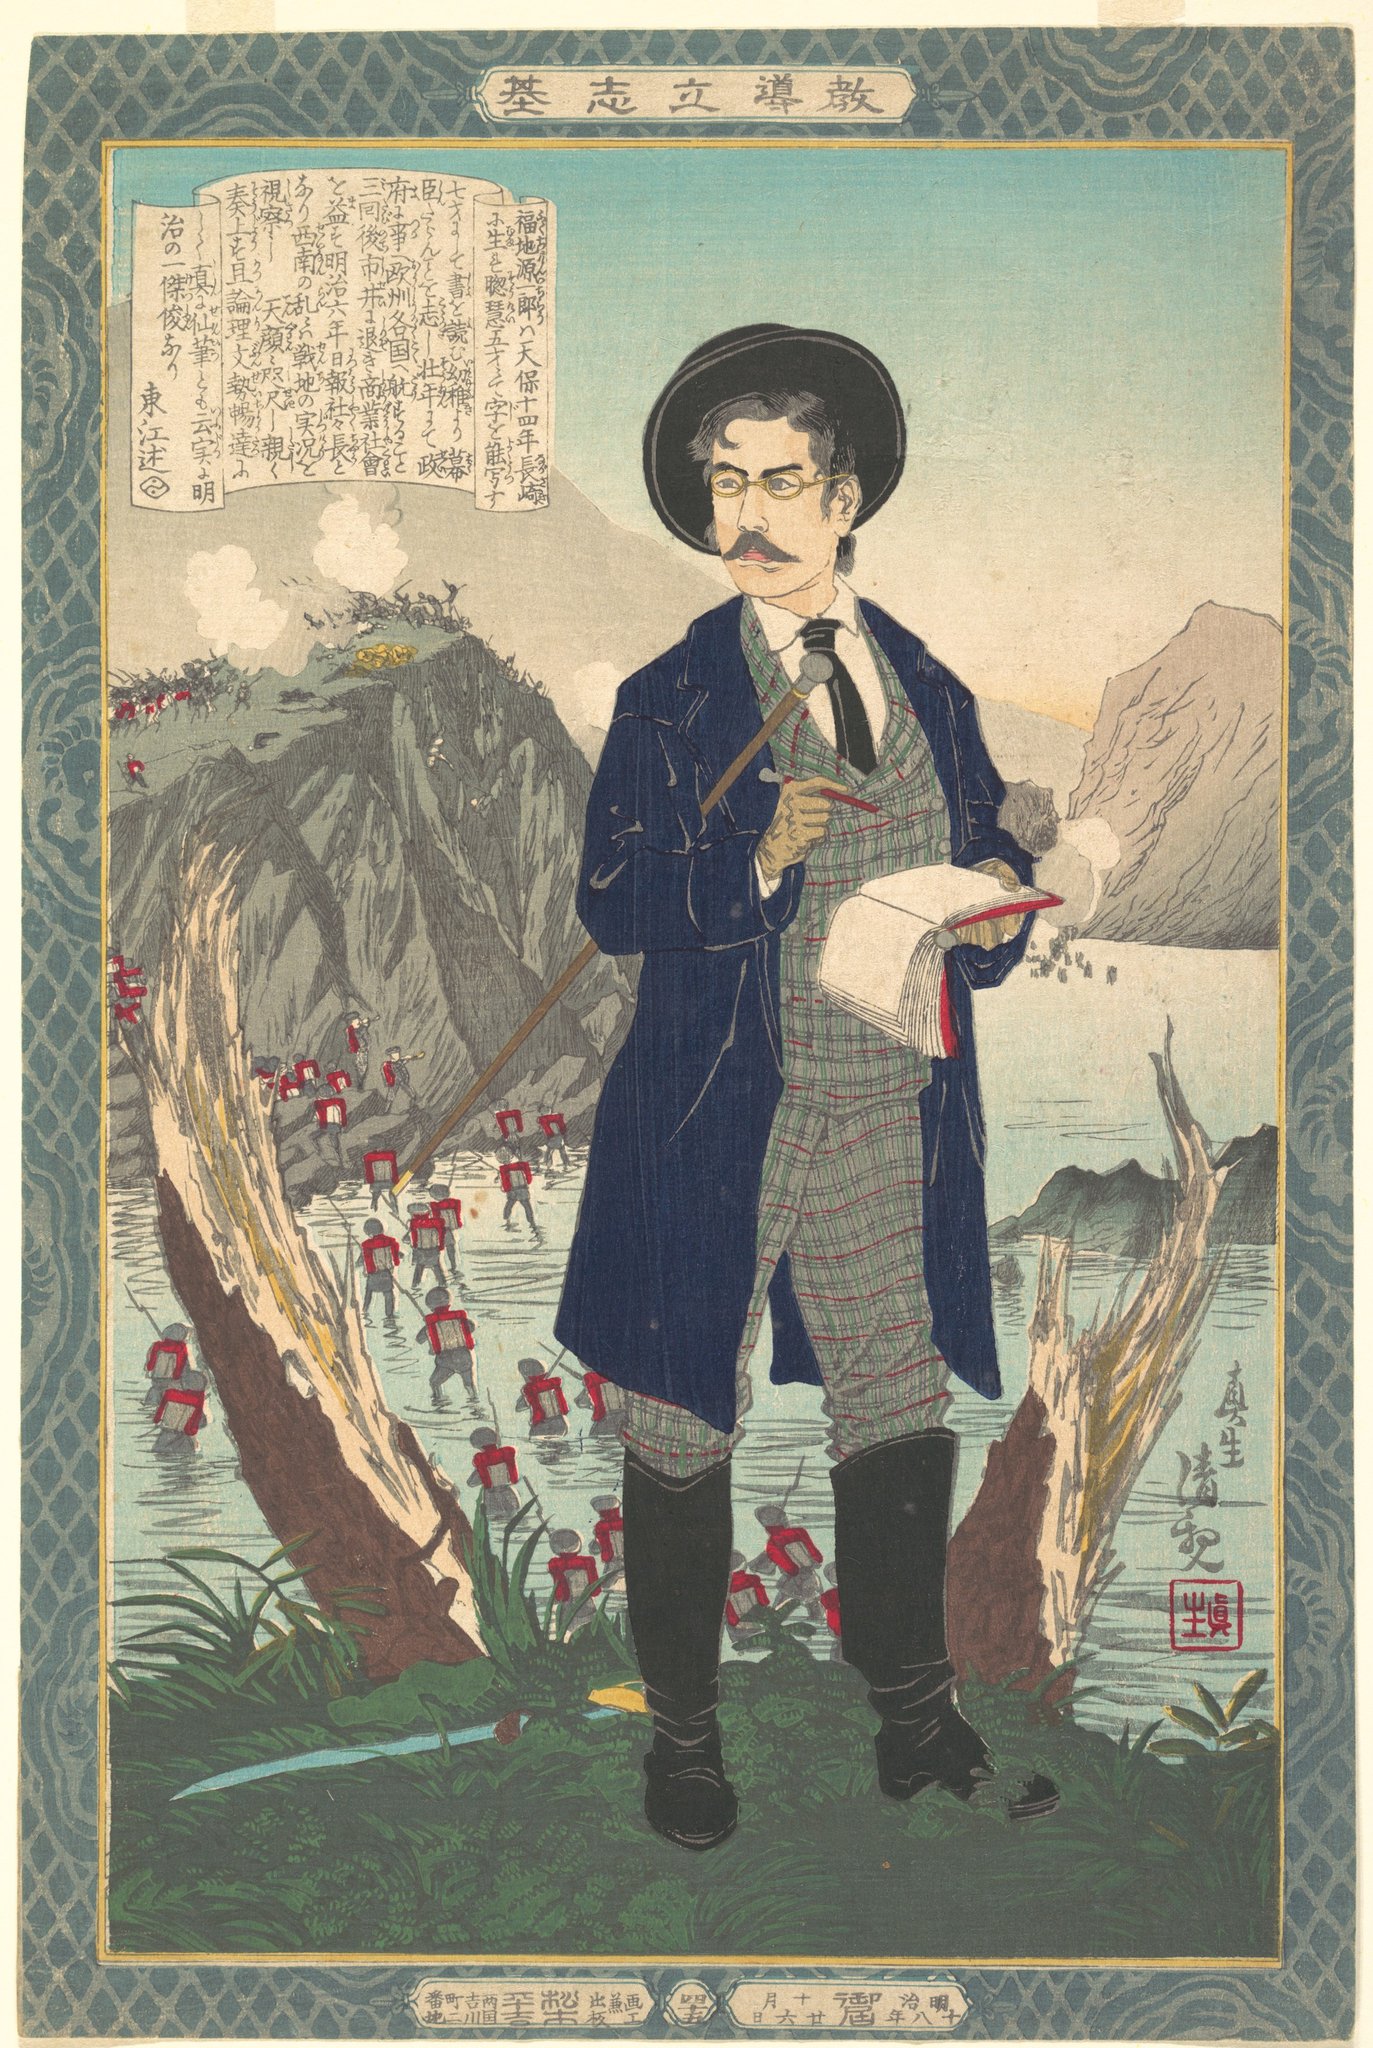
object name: print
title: Portrait of Fukuchi Gen'ichiro (1843–?)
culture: japanese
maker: kobayashi kiyochika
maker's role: artist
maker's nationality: japanese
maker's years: 1847-1915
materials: ink, paper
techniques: woodblock print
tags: men,portraits,writing